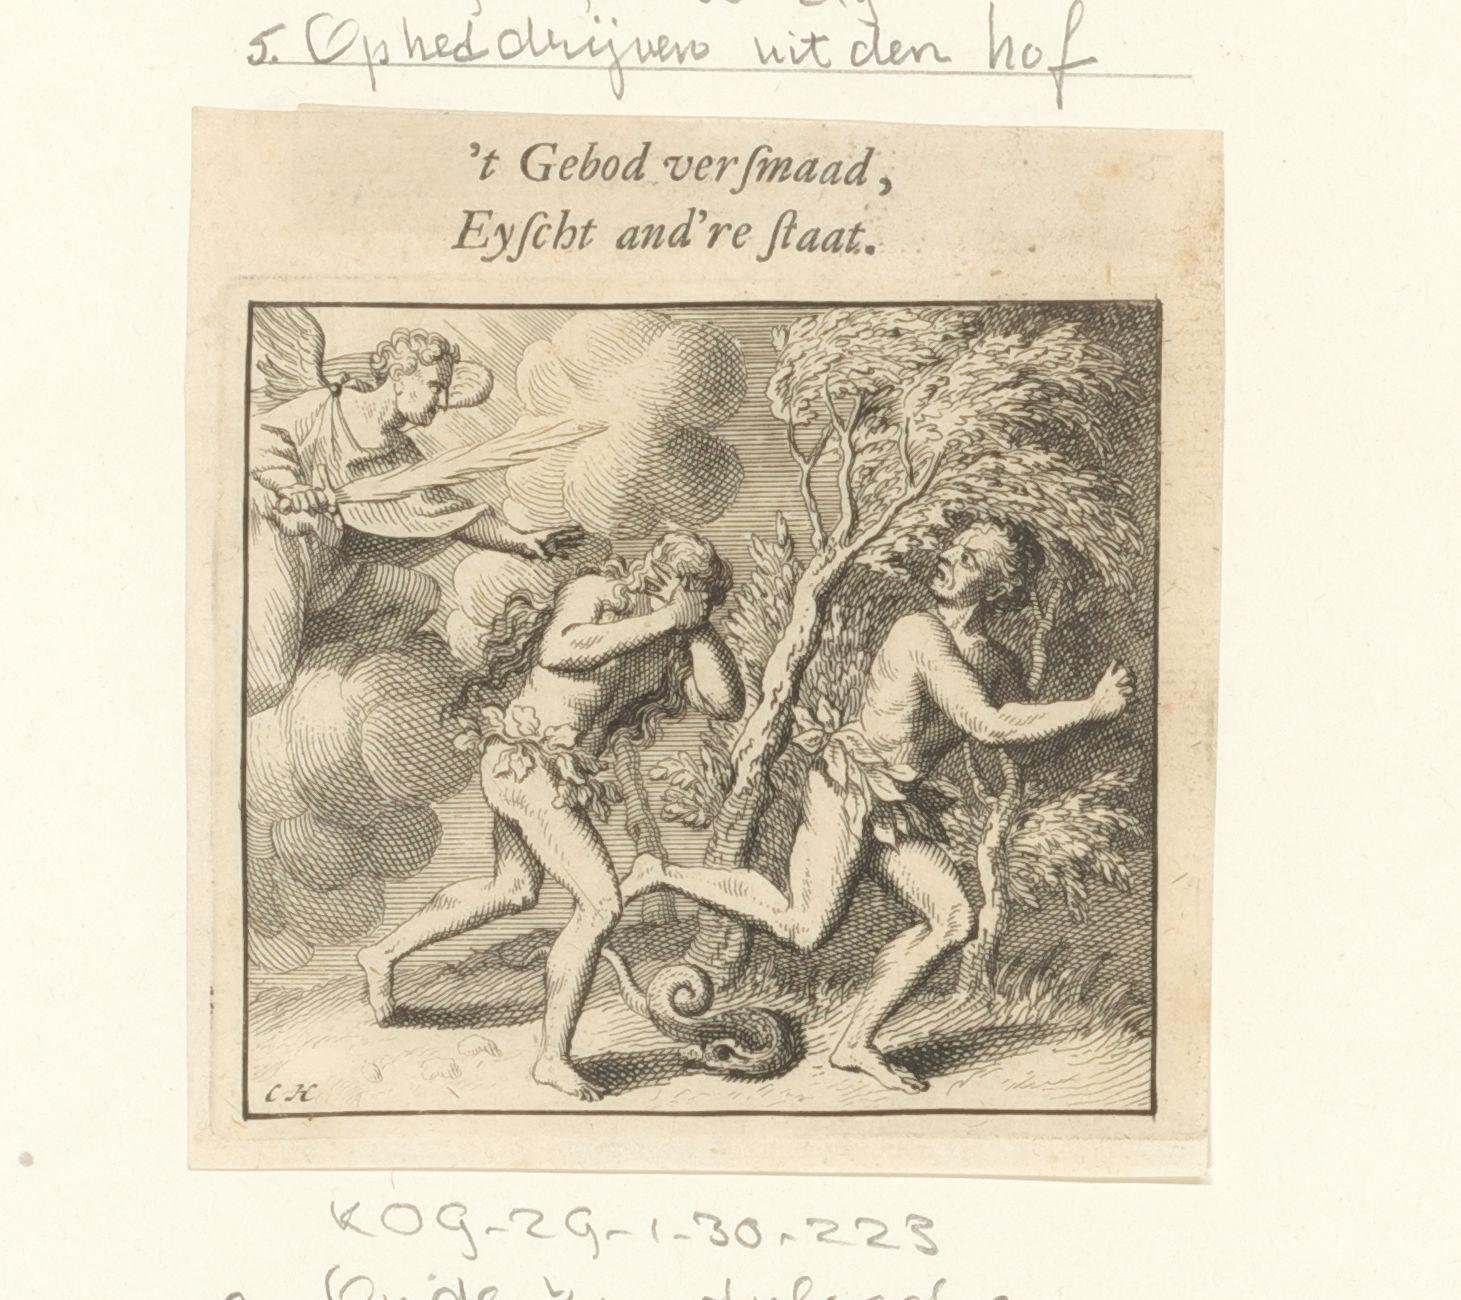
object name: print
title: Adam en Eva worden uit het Paradijs verstoten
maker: cornelis huyberts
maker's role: print maker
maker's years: 1669-1709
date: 1725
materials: paper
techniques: etching, letterpress printing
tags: god expels adam and eve from paradise and has the tree of life guarded by an angel with a flaming sword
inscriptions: collector's mark: Lugt 1641, stamp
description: Prent uit: Graauwhart, Hendrik. Voorbeeldelyke zeede-lessen, genoomen uyt den eersten toestand des werelds (...). Amsterdam: Johannes Ratelband, 1725. Prent ook gebruikt voor eerdere en (1709) latere uitgave (1756, 1761 en 1764).